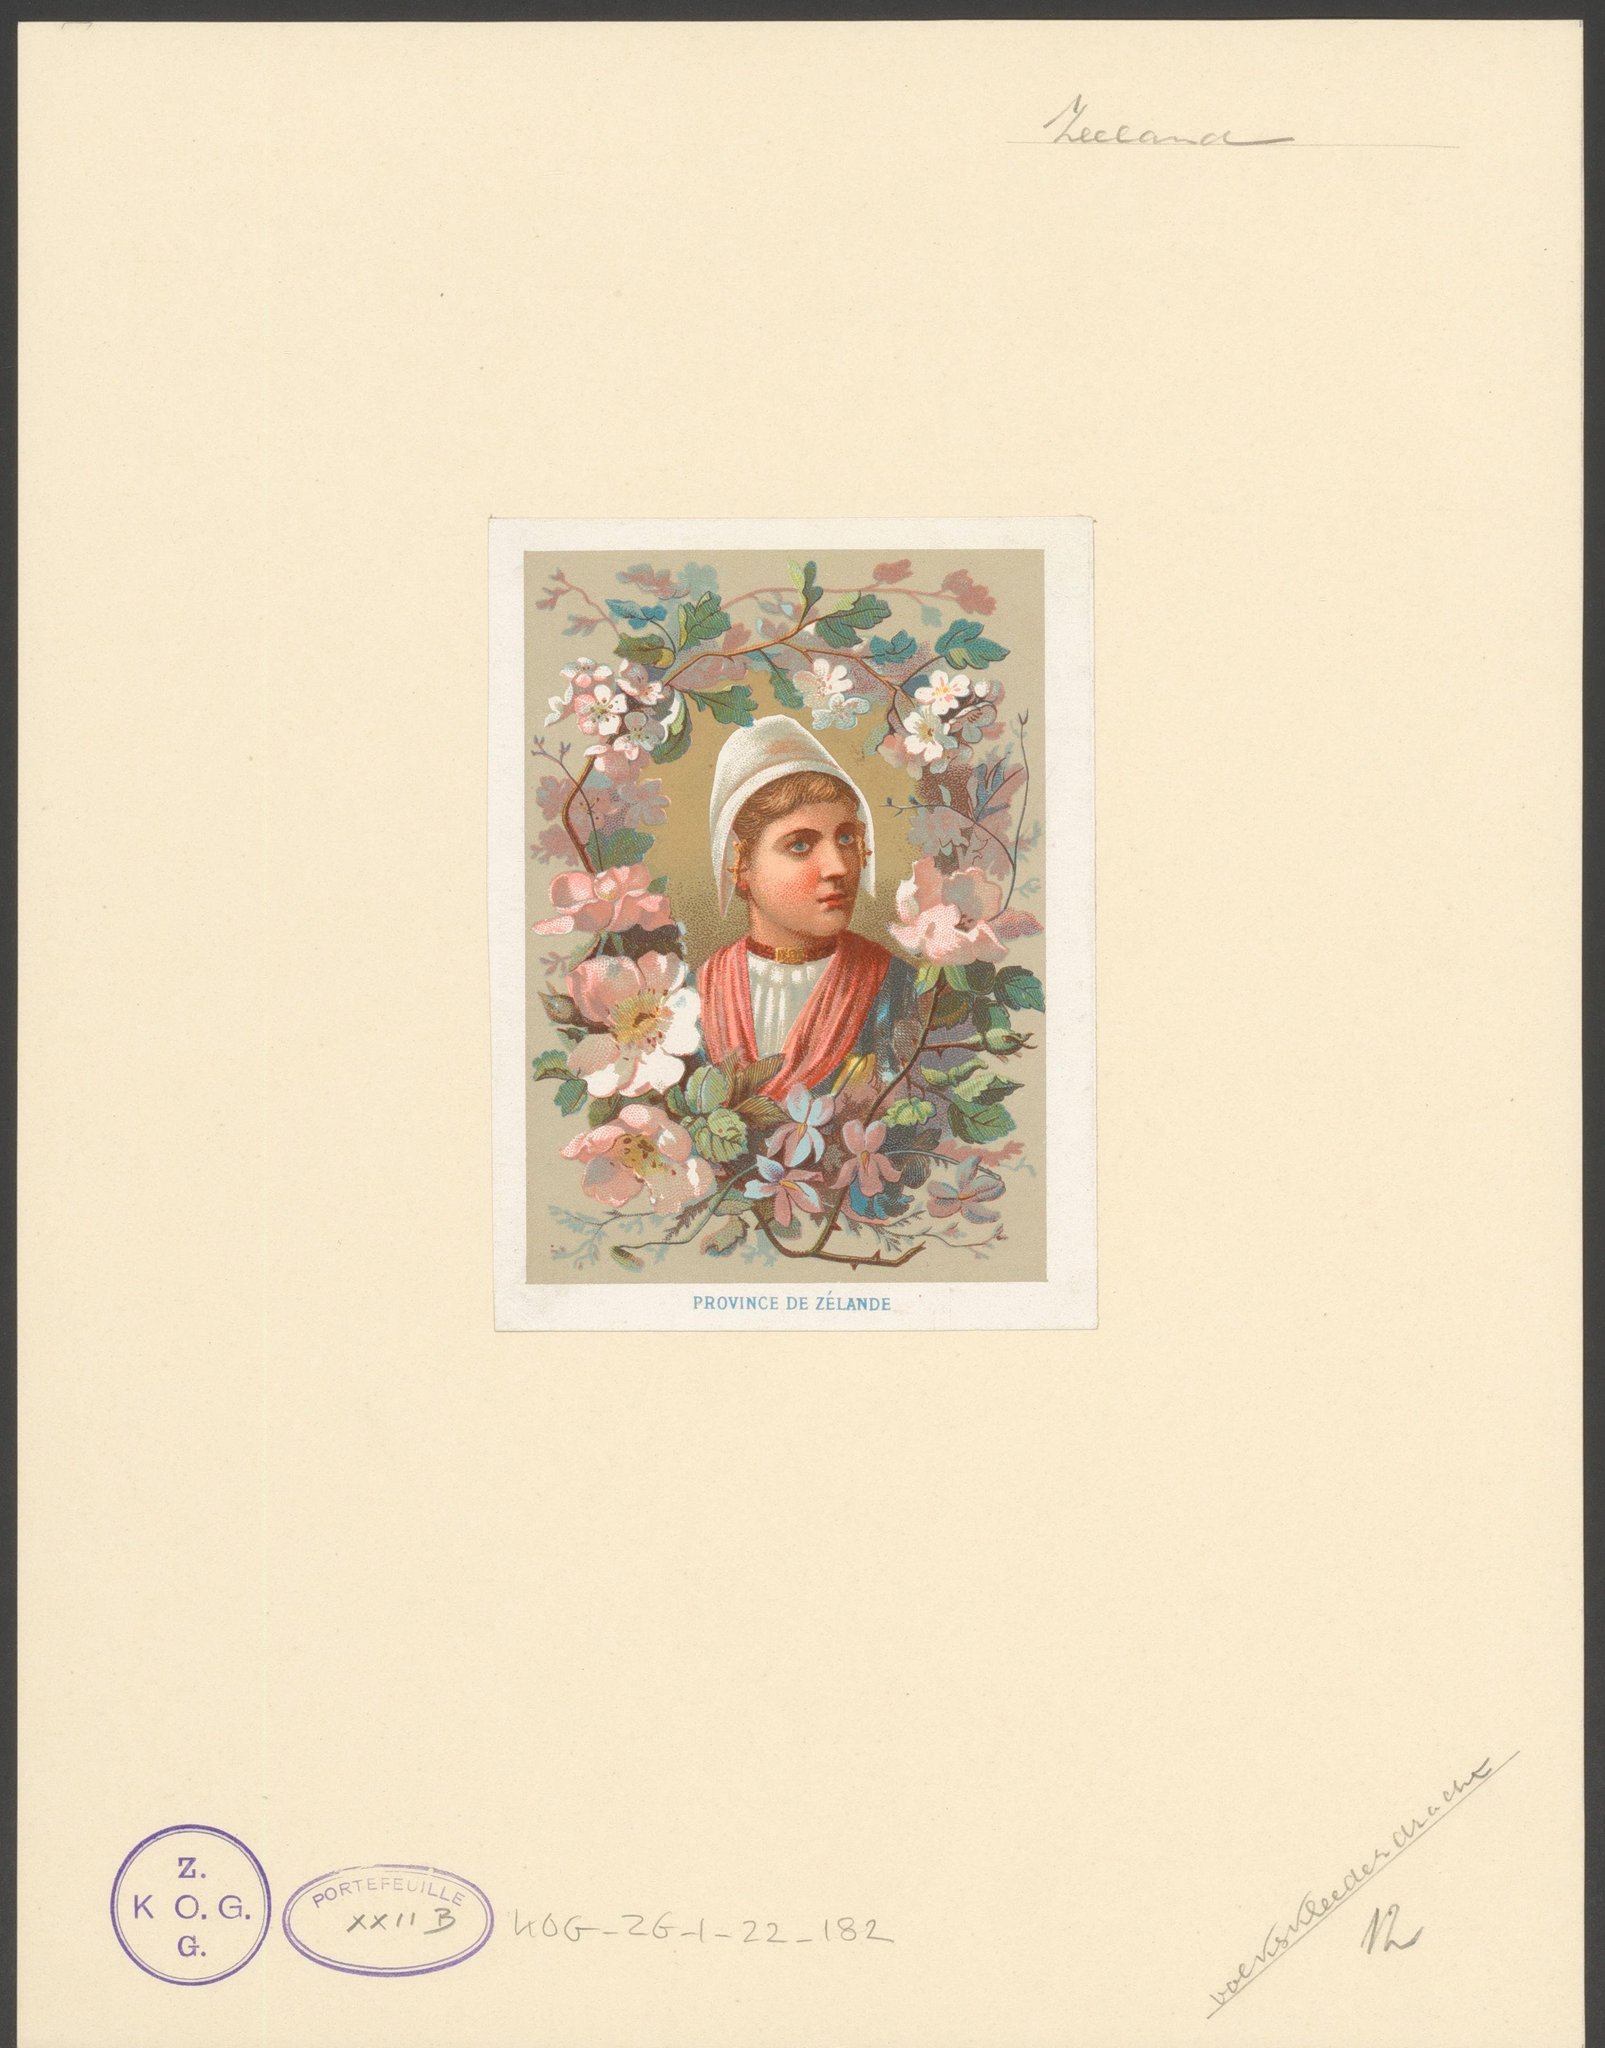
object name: print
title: Bustes van vrouwen in klederdracht binnen bloemenkrans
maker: Anonymous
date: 1890-1940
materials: paper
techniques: chromolithography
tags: clothes, costume (+ women's clothes), folk costume, regional costume, zeeland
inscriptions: collector's mark: Lugt 1641, collector's mark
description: Buste van een Zeeuwse vrouw, met kap, binnen een krans van bloemen. Onderwerpsrubrieken binnen de Atlas Zeden en Gewoonten: De Kleeding, Volkskleederdracht, Zeeland.